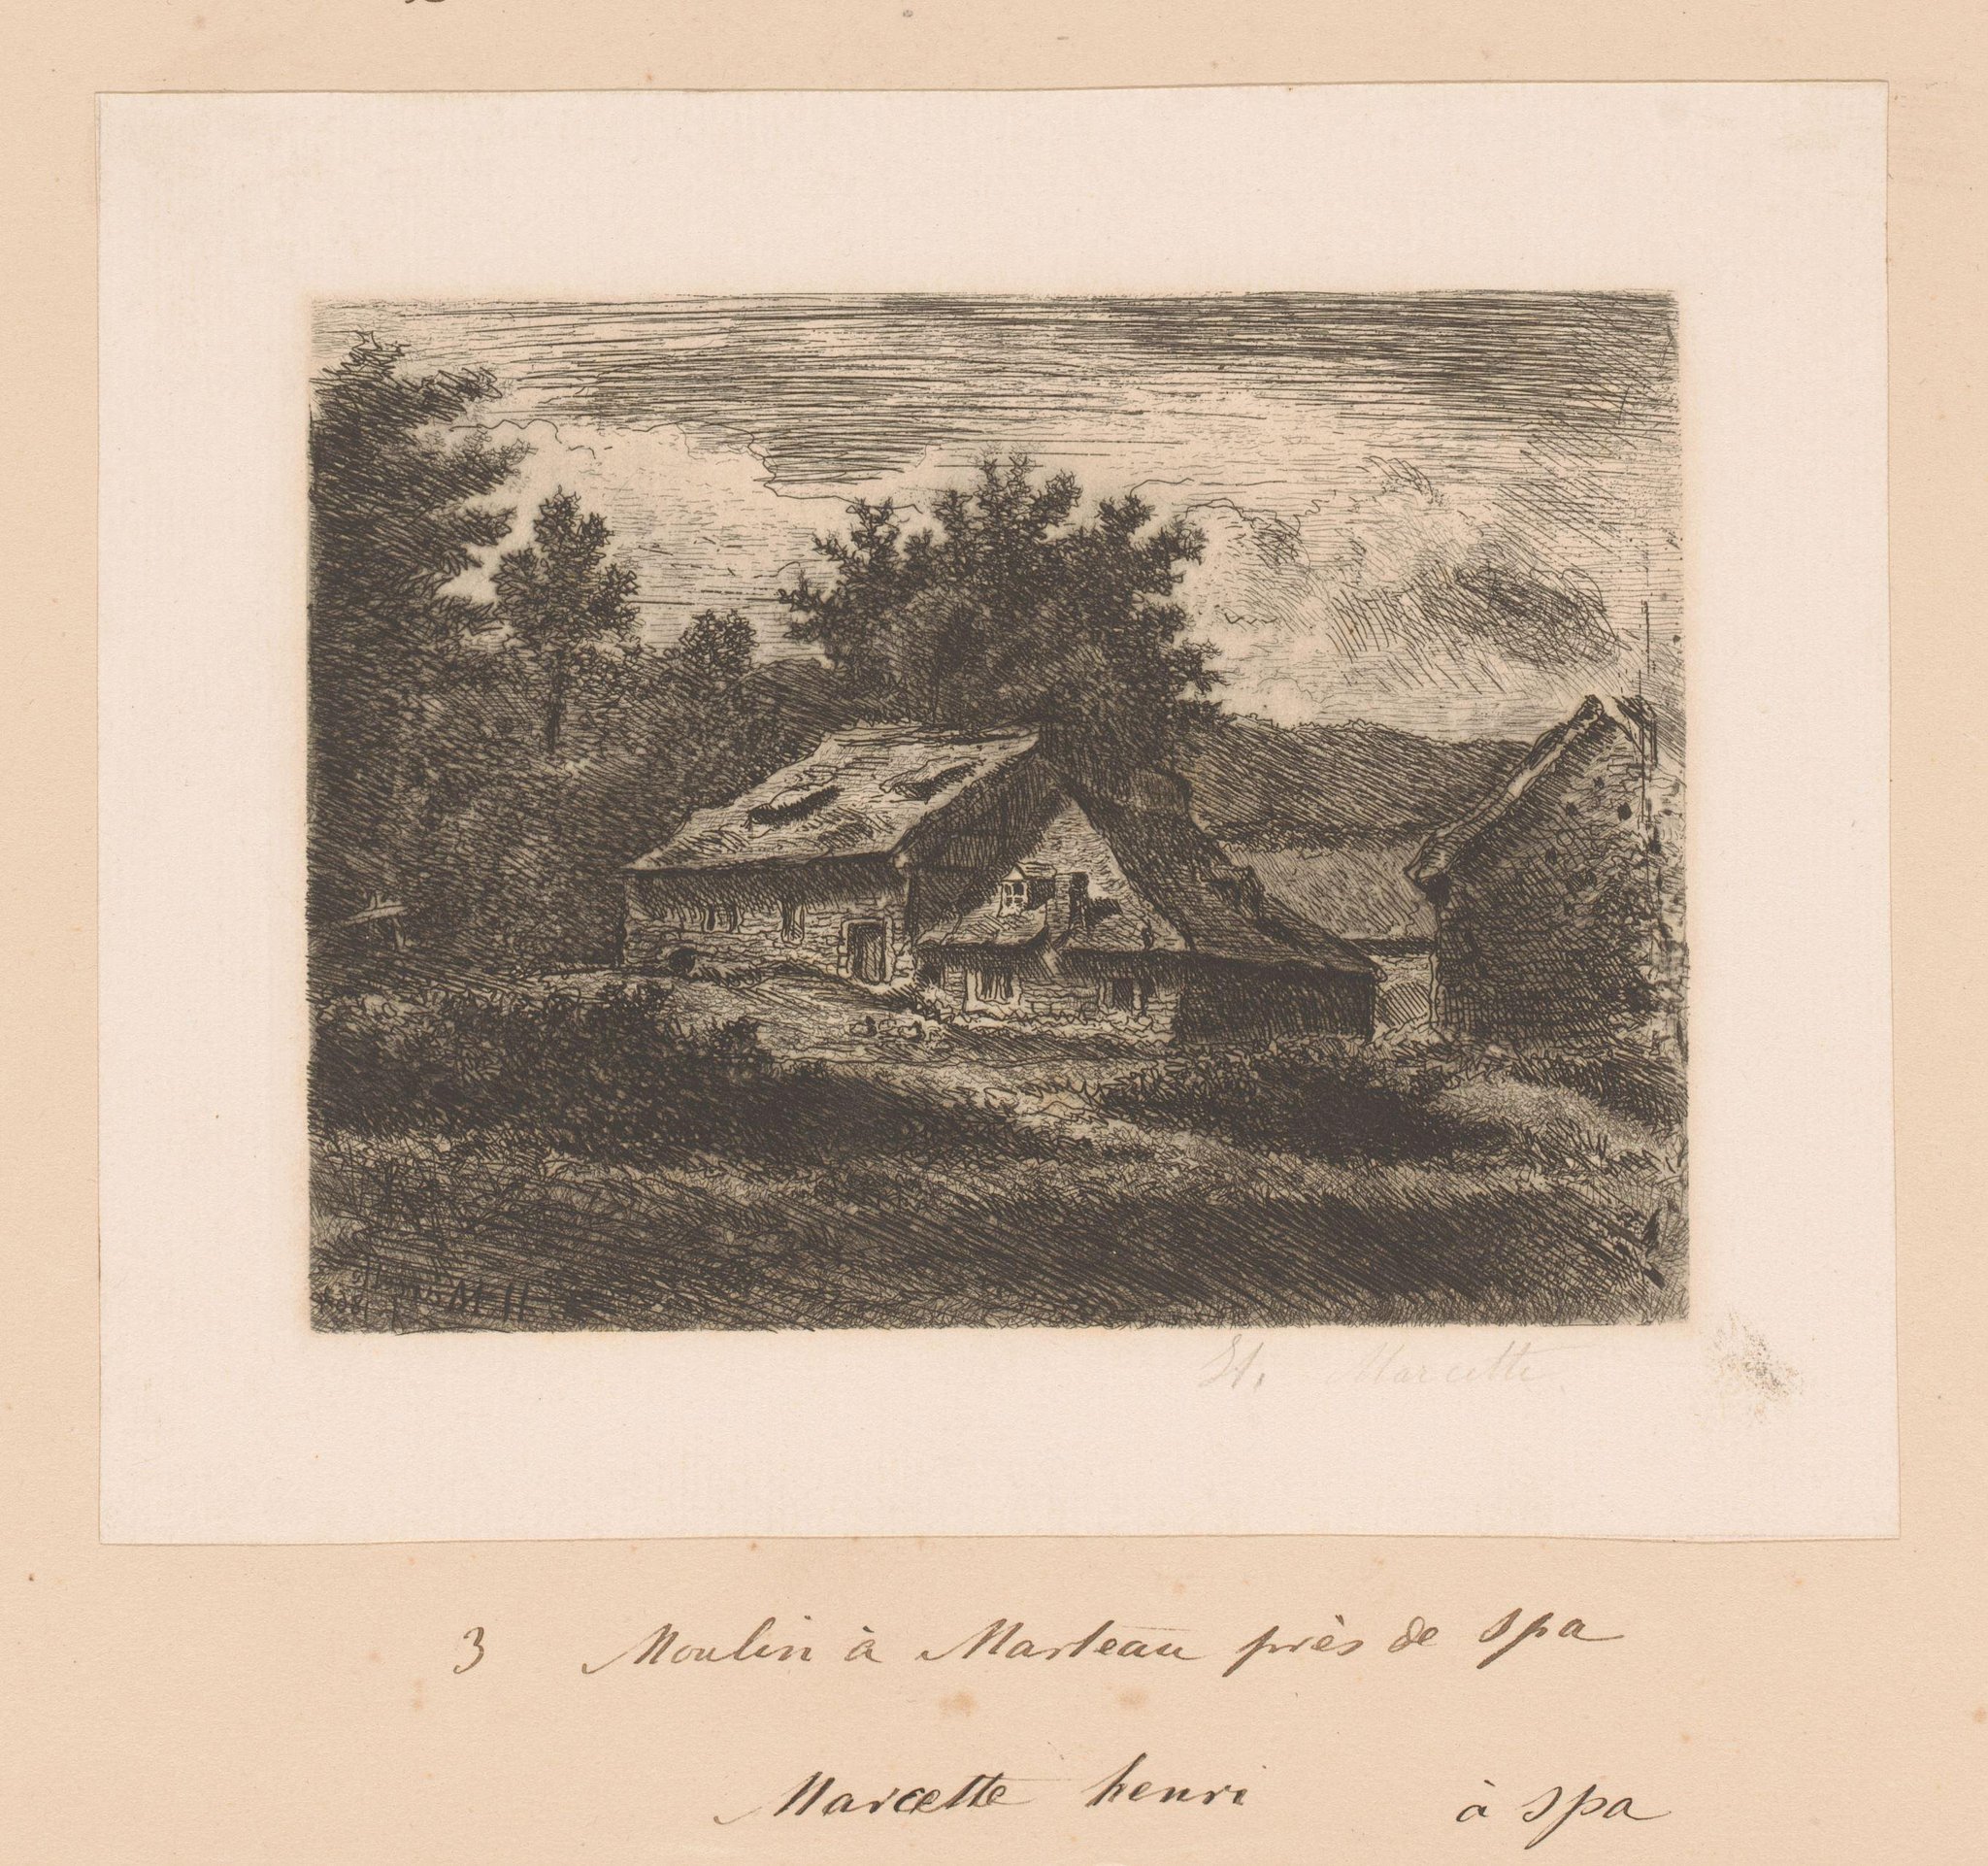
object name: print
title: Molen te Marteau bij Spa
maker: henri joseph marcette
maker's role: print maker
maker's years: 1824-1890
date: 1861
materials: paper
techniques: etching, intaglio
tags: farm or solitary house in landscape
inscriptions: collector's mark: Lugt 2228